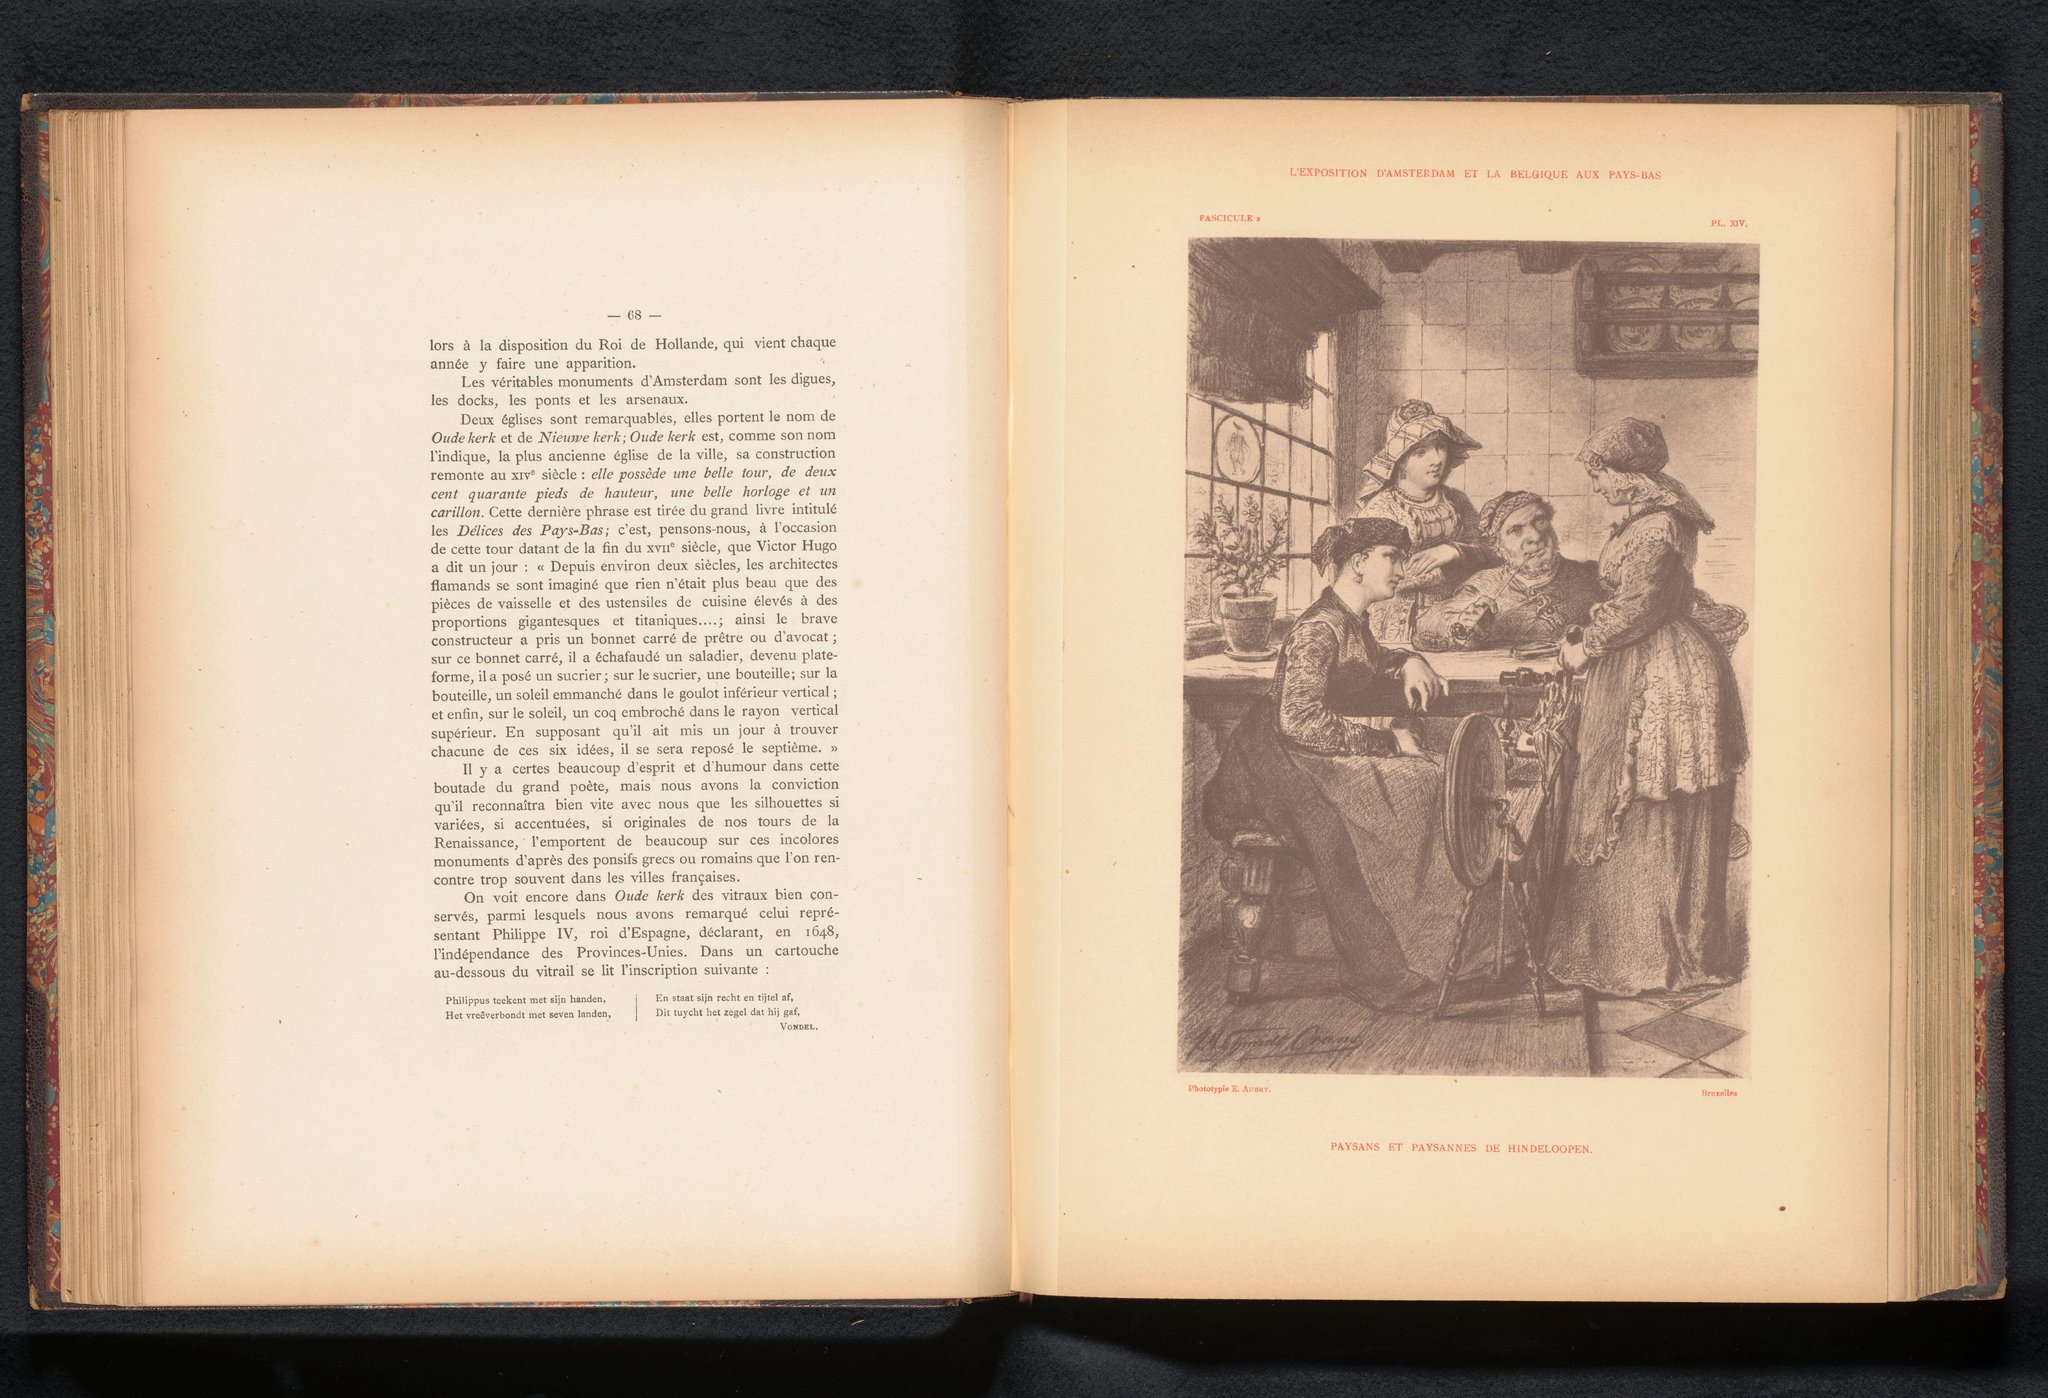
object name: reproduction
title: Reproductie van een prent van een boer en boerinnen aan de keukentafel te Hindeloopen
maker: emile aubry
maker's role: print maker, printer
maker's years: 1829-1900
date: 1878-1883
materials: paper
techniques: photograph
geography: brussels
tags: kitchen, farmers, spinning-wheel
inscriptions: inscription: ‘Fascicule 2/ PL. XIV’